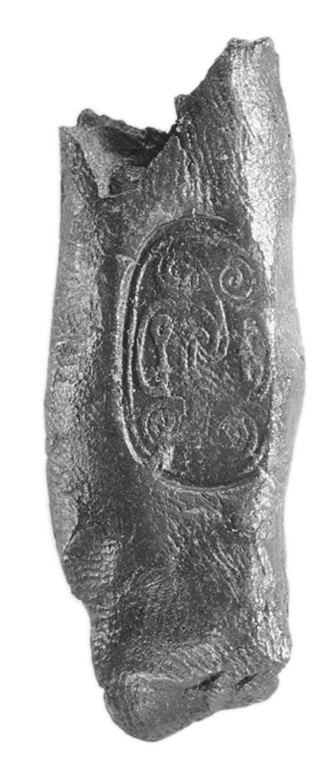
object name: sealing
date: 1981-1640 BCE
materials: mud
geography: egypt